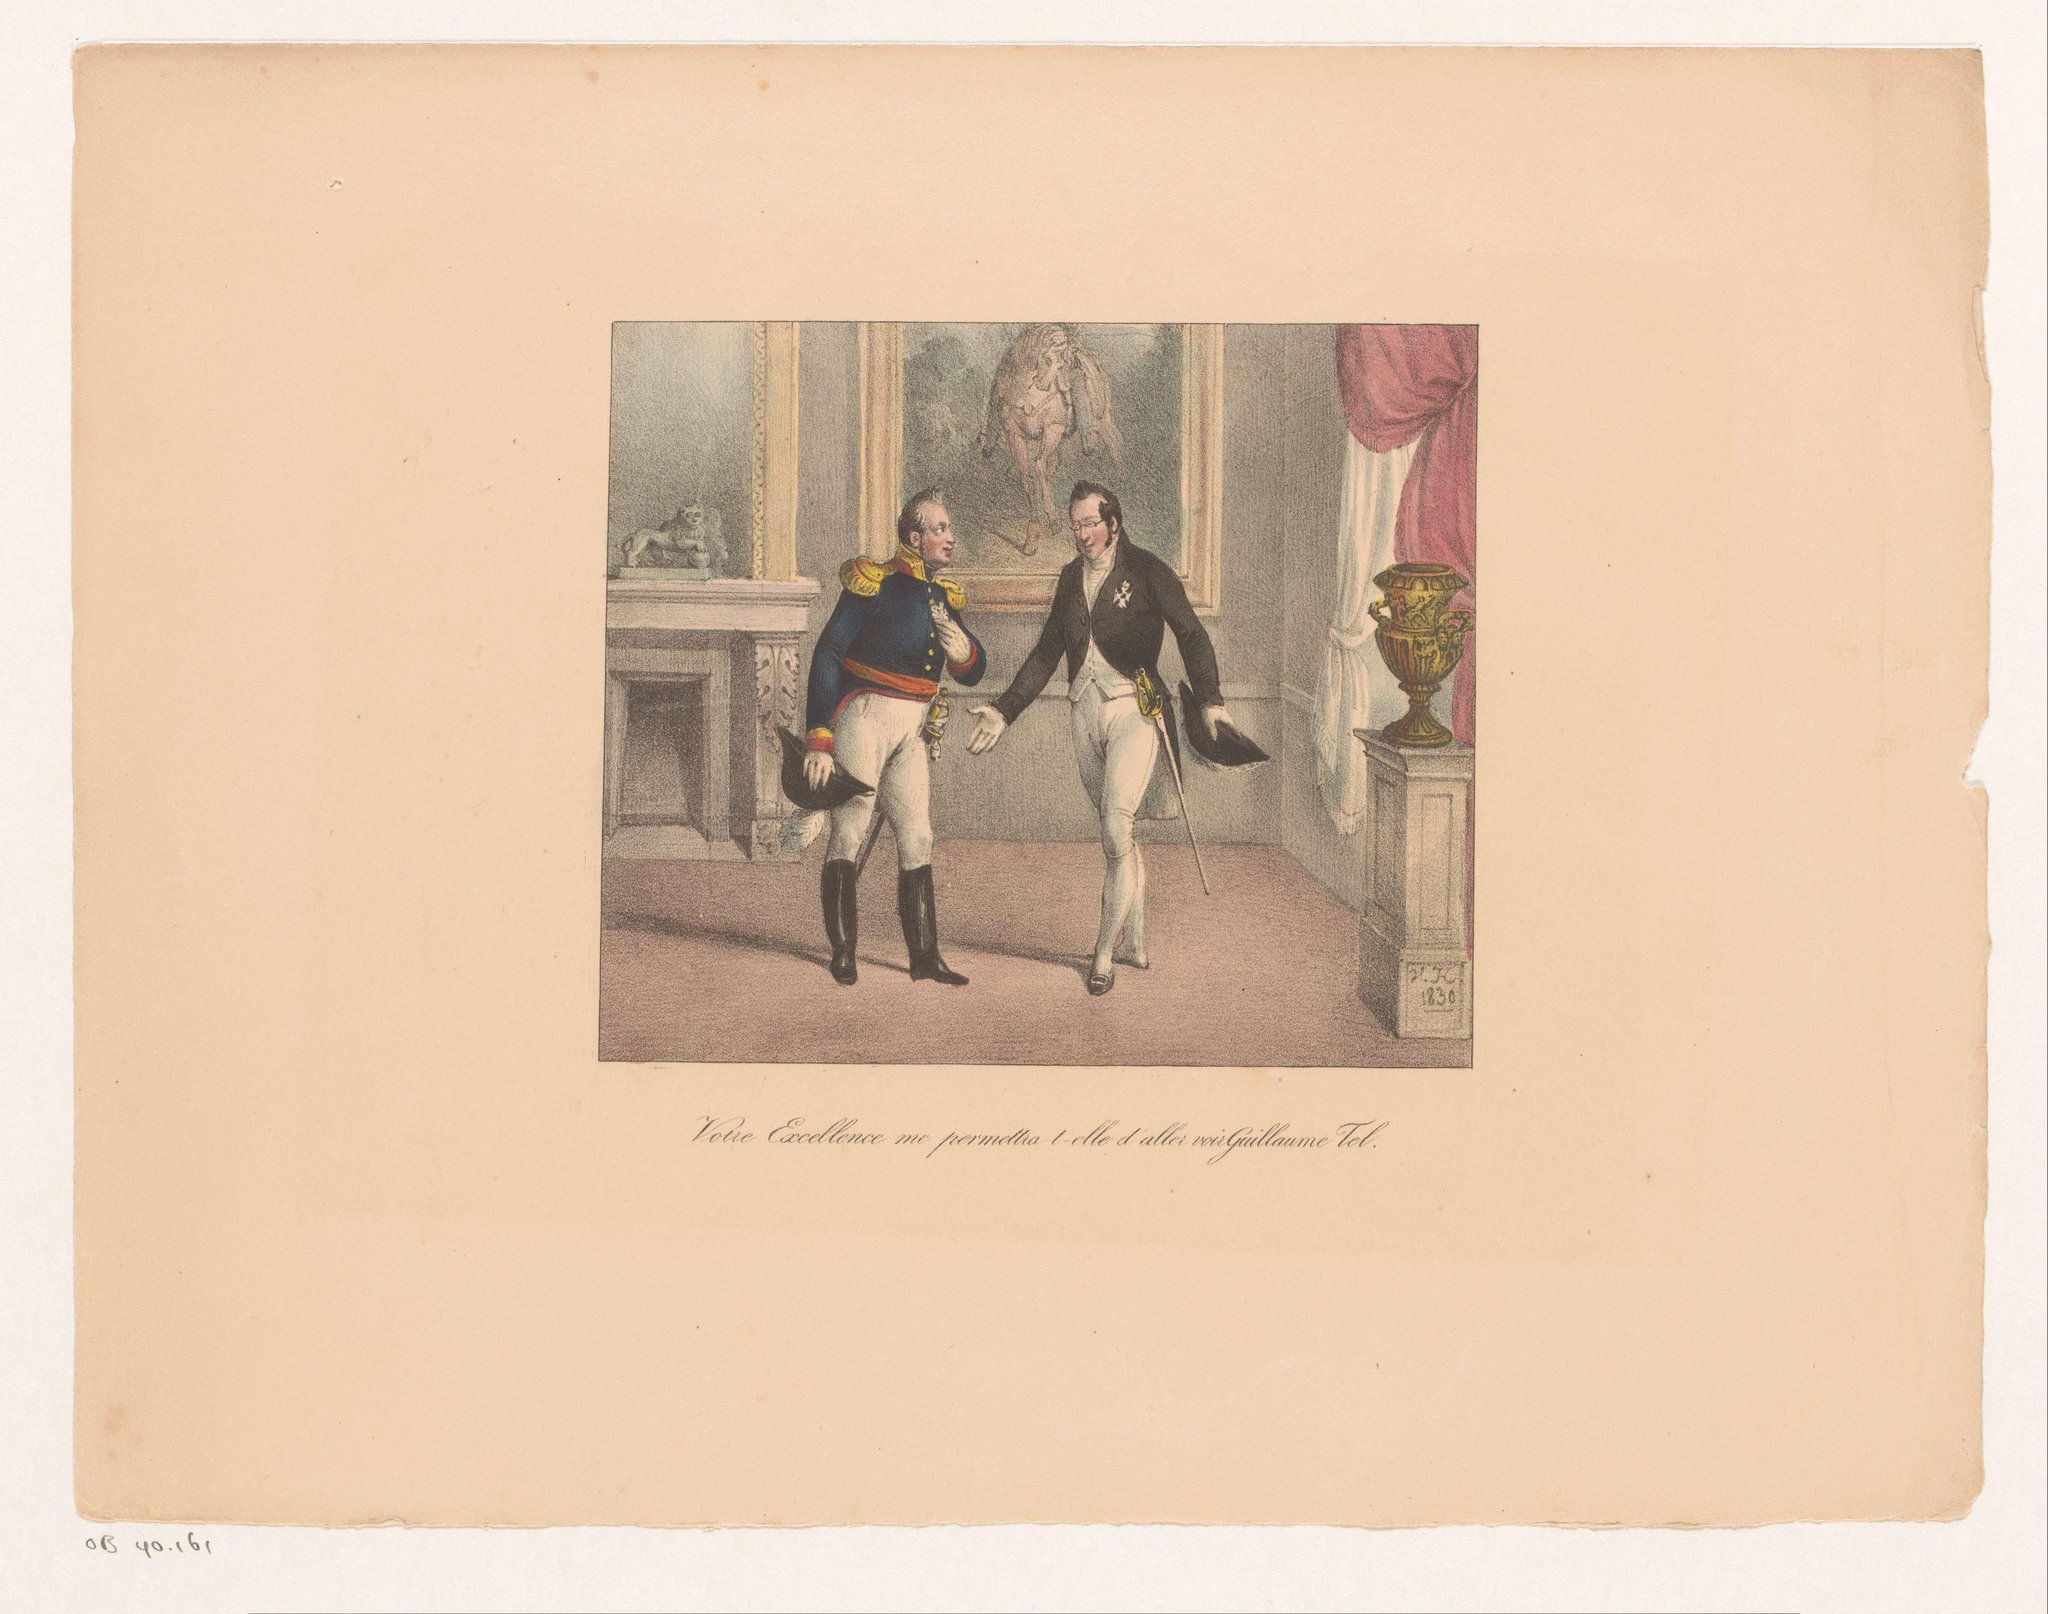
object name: print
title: Koning Willem I vraagt zijn ceremoniemeester toestemming om het stuk Willem Tell te gaan zien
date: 1830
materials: paper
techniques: lithograph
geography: brussels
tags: the hague, berlin, william i of the netherlands, william tell, ruler in informal contact with his subjects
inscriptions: collector's mark: Lugt 2228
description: Prent is ongenummerd maar verwant aan de serie van 24 platen met ontmoetingen met koning Willem I, verschenen onder de titel 'Les rencontres' in 1829-1830.